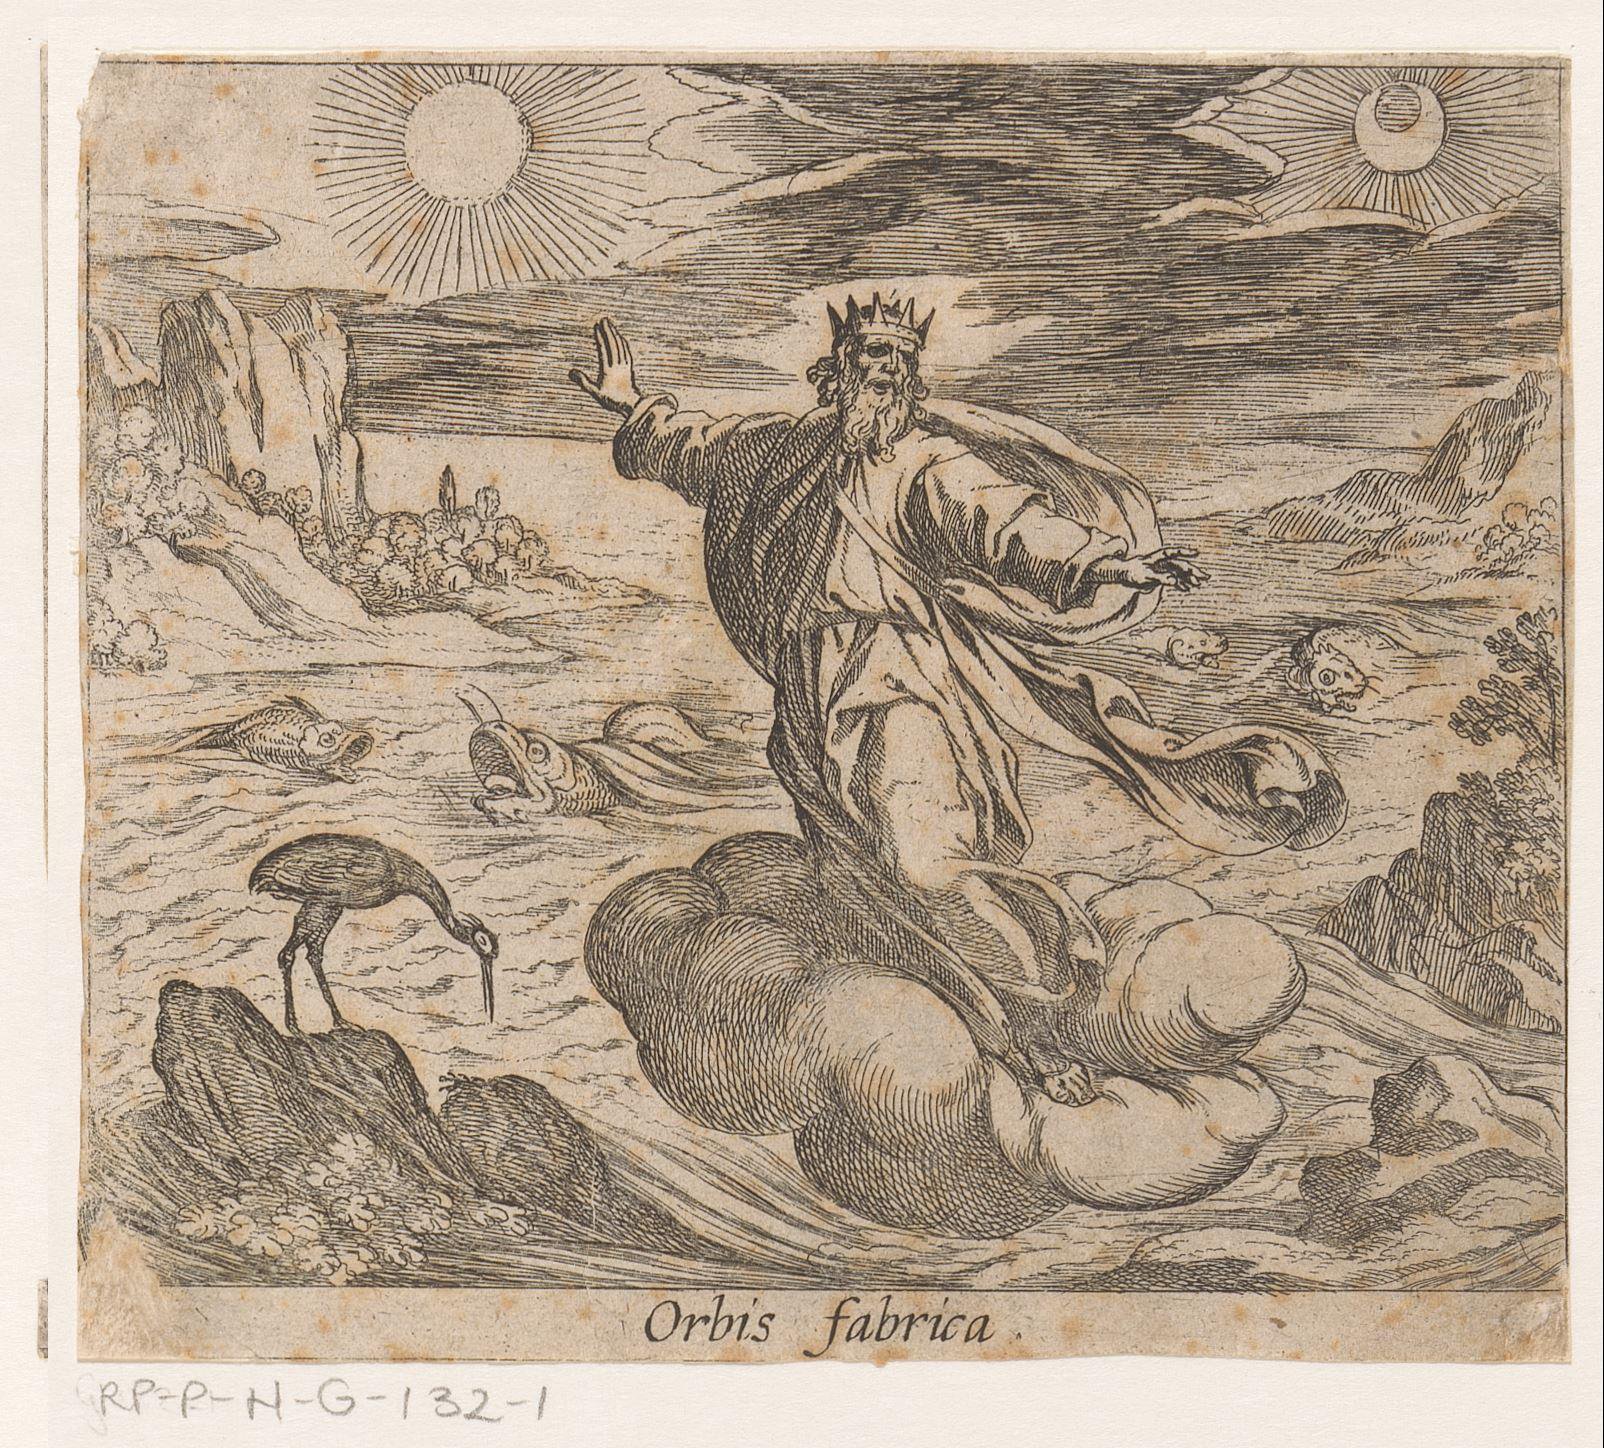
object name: print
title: Medea verwoest familie en huis van Jason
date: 1606-1638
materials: paper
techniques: etching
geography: italy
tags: medea kills her two children; she flees from corinth in a chariot drawn by winged dragons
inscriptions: collector's mark: ‘Hinloopen’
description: Medea zit op haar wagen die wordt voortgetrokken door twee draken. Ze verwoest het huis en de familie van Jason. Het huis gaat in vlammen op. Titel in het Latijn in ondermarge.